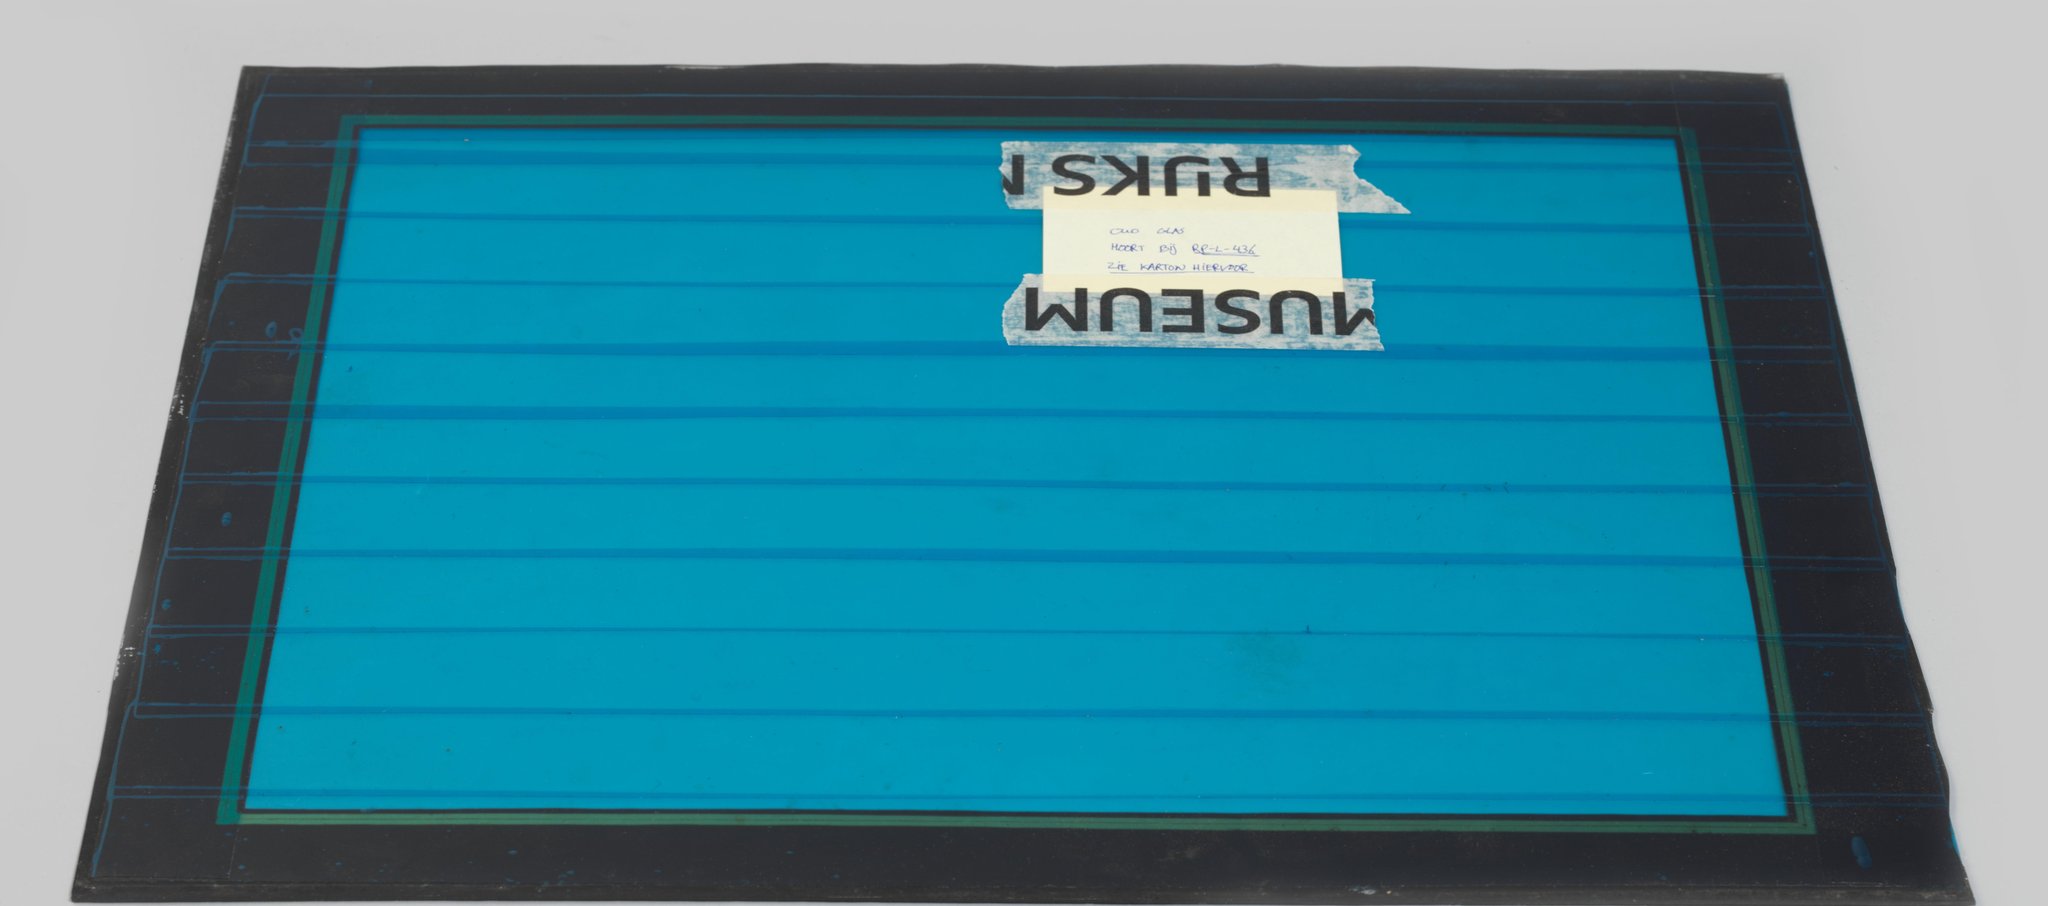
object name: sheet glass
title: Glasplaat horend bij een vergulde en gesneden Lodewijk XVI lijst met vierkante hoekornamenten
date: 1900-1925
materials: glass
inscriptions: label: ‘HISTORISCHE TENTOONSTELLING // DER STAD AMSTERDAM 1925 // Eigendom van Mr. G. Vissering // de Lairessestraat I65 // tekening in lijst // Nr. 2847 stedelyk’, label: ‘Na mijn dood volgens // beloft aan tante Elske is // deze aquarel voor Maja // en Jan Westerman Tolstijn // Amsterdam 1 ??? ??? // 1 April 1939’